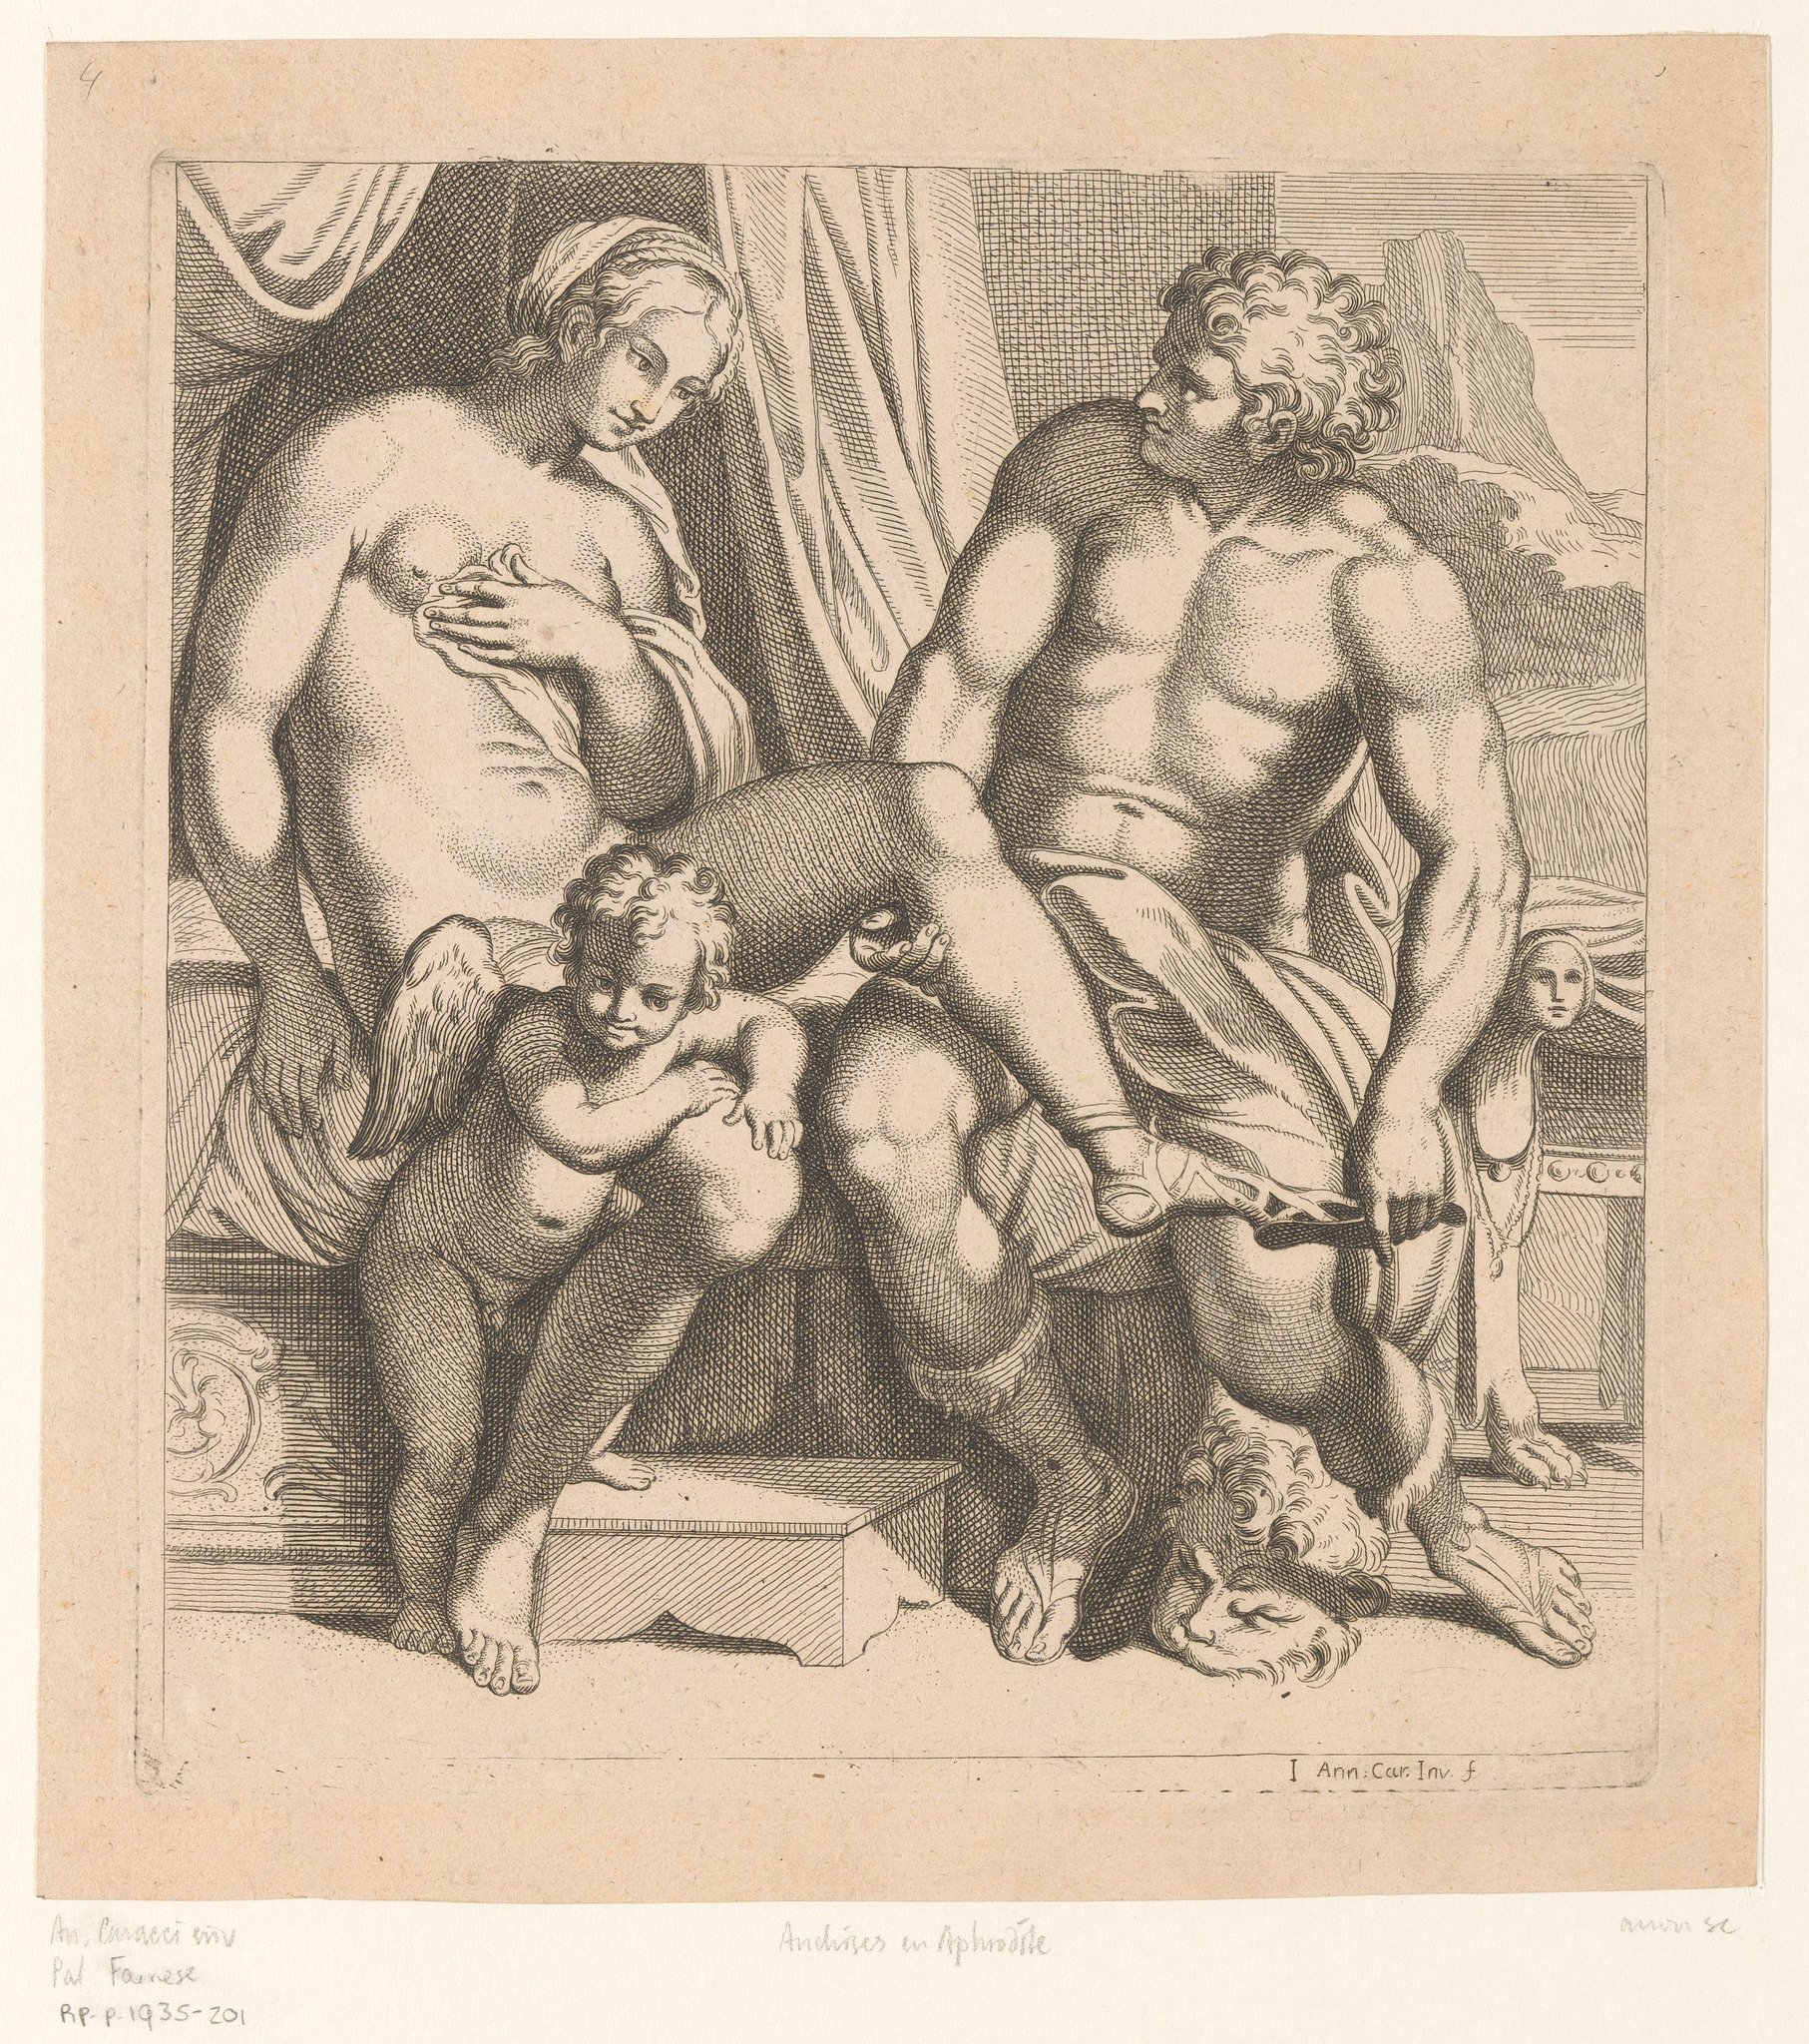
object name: print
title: Schilderingen in Palazzo Farnese te Rome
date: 1570-1659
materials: paper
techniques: etching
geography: rome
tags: venus and anchises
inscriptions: collector's mark: Lugt 2228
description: Venus en Anchises zitten op bed. Anchises trekt de sandaal van Venus uit. Op de voorgrond leunt Amor op het been van Venus.